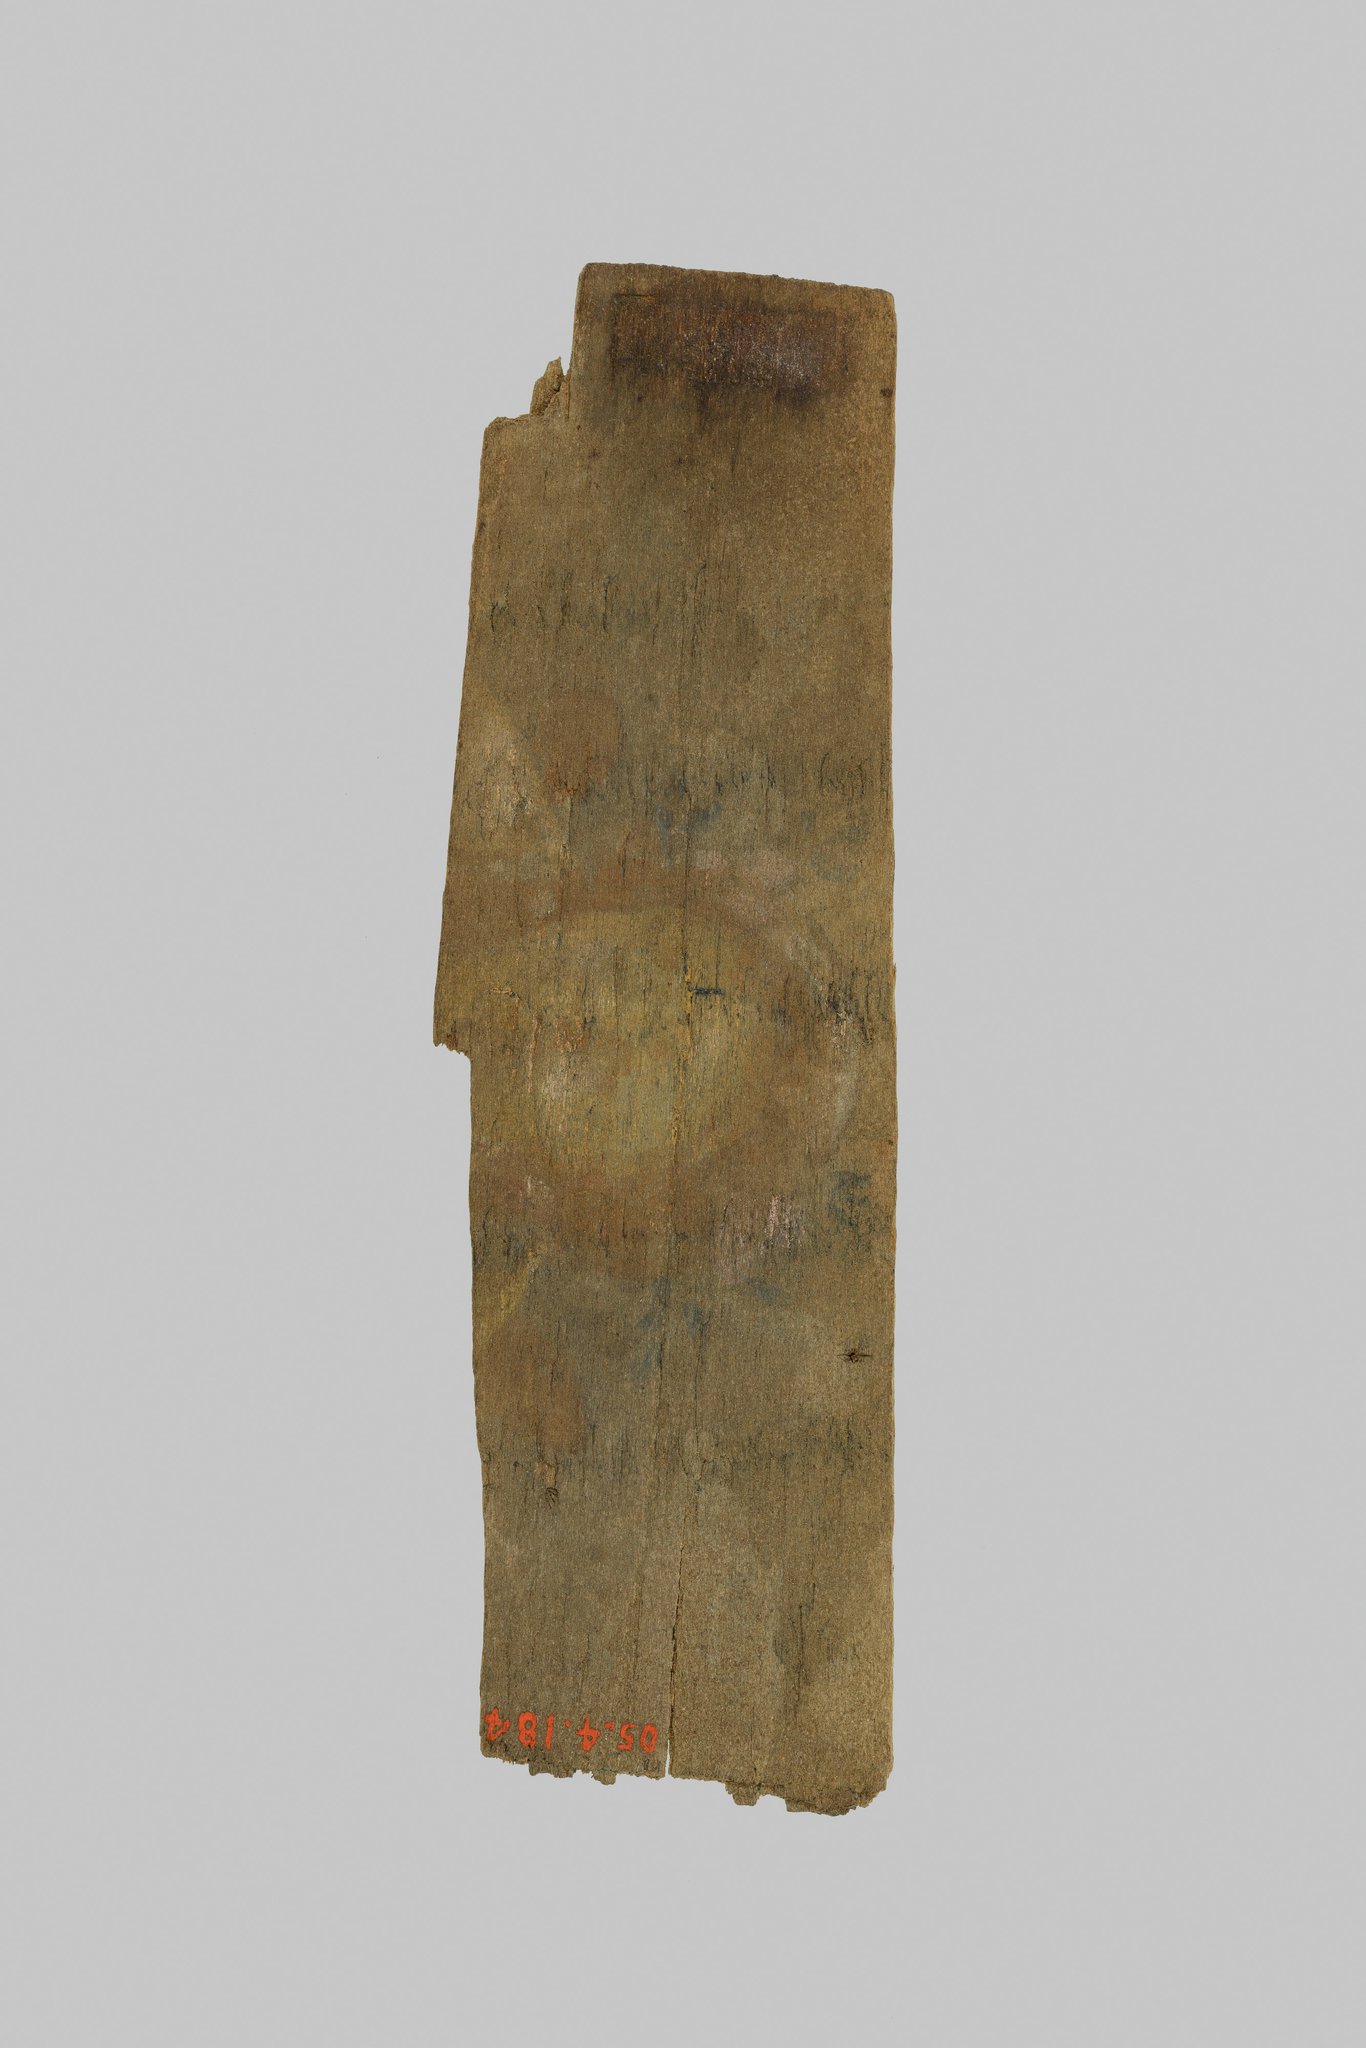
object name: mummy label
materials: pigment, wood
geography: egypt